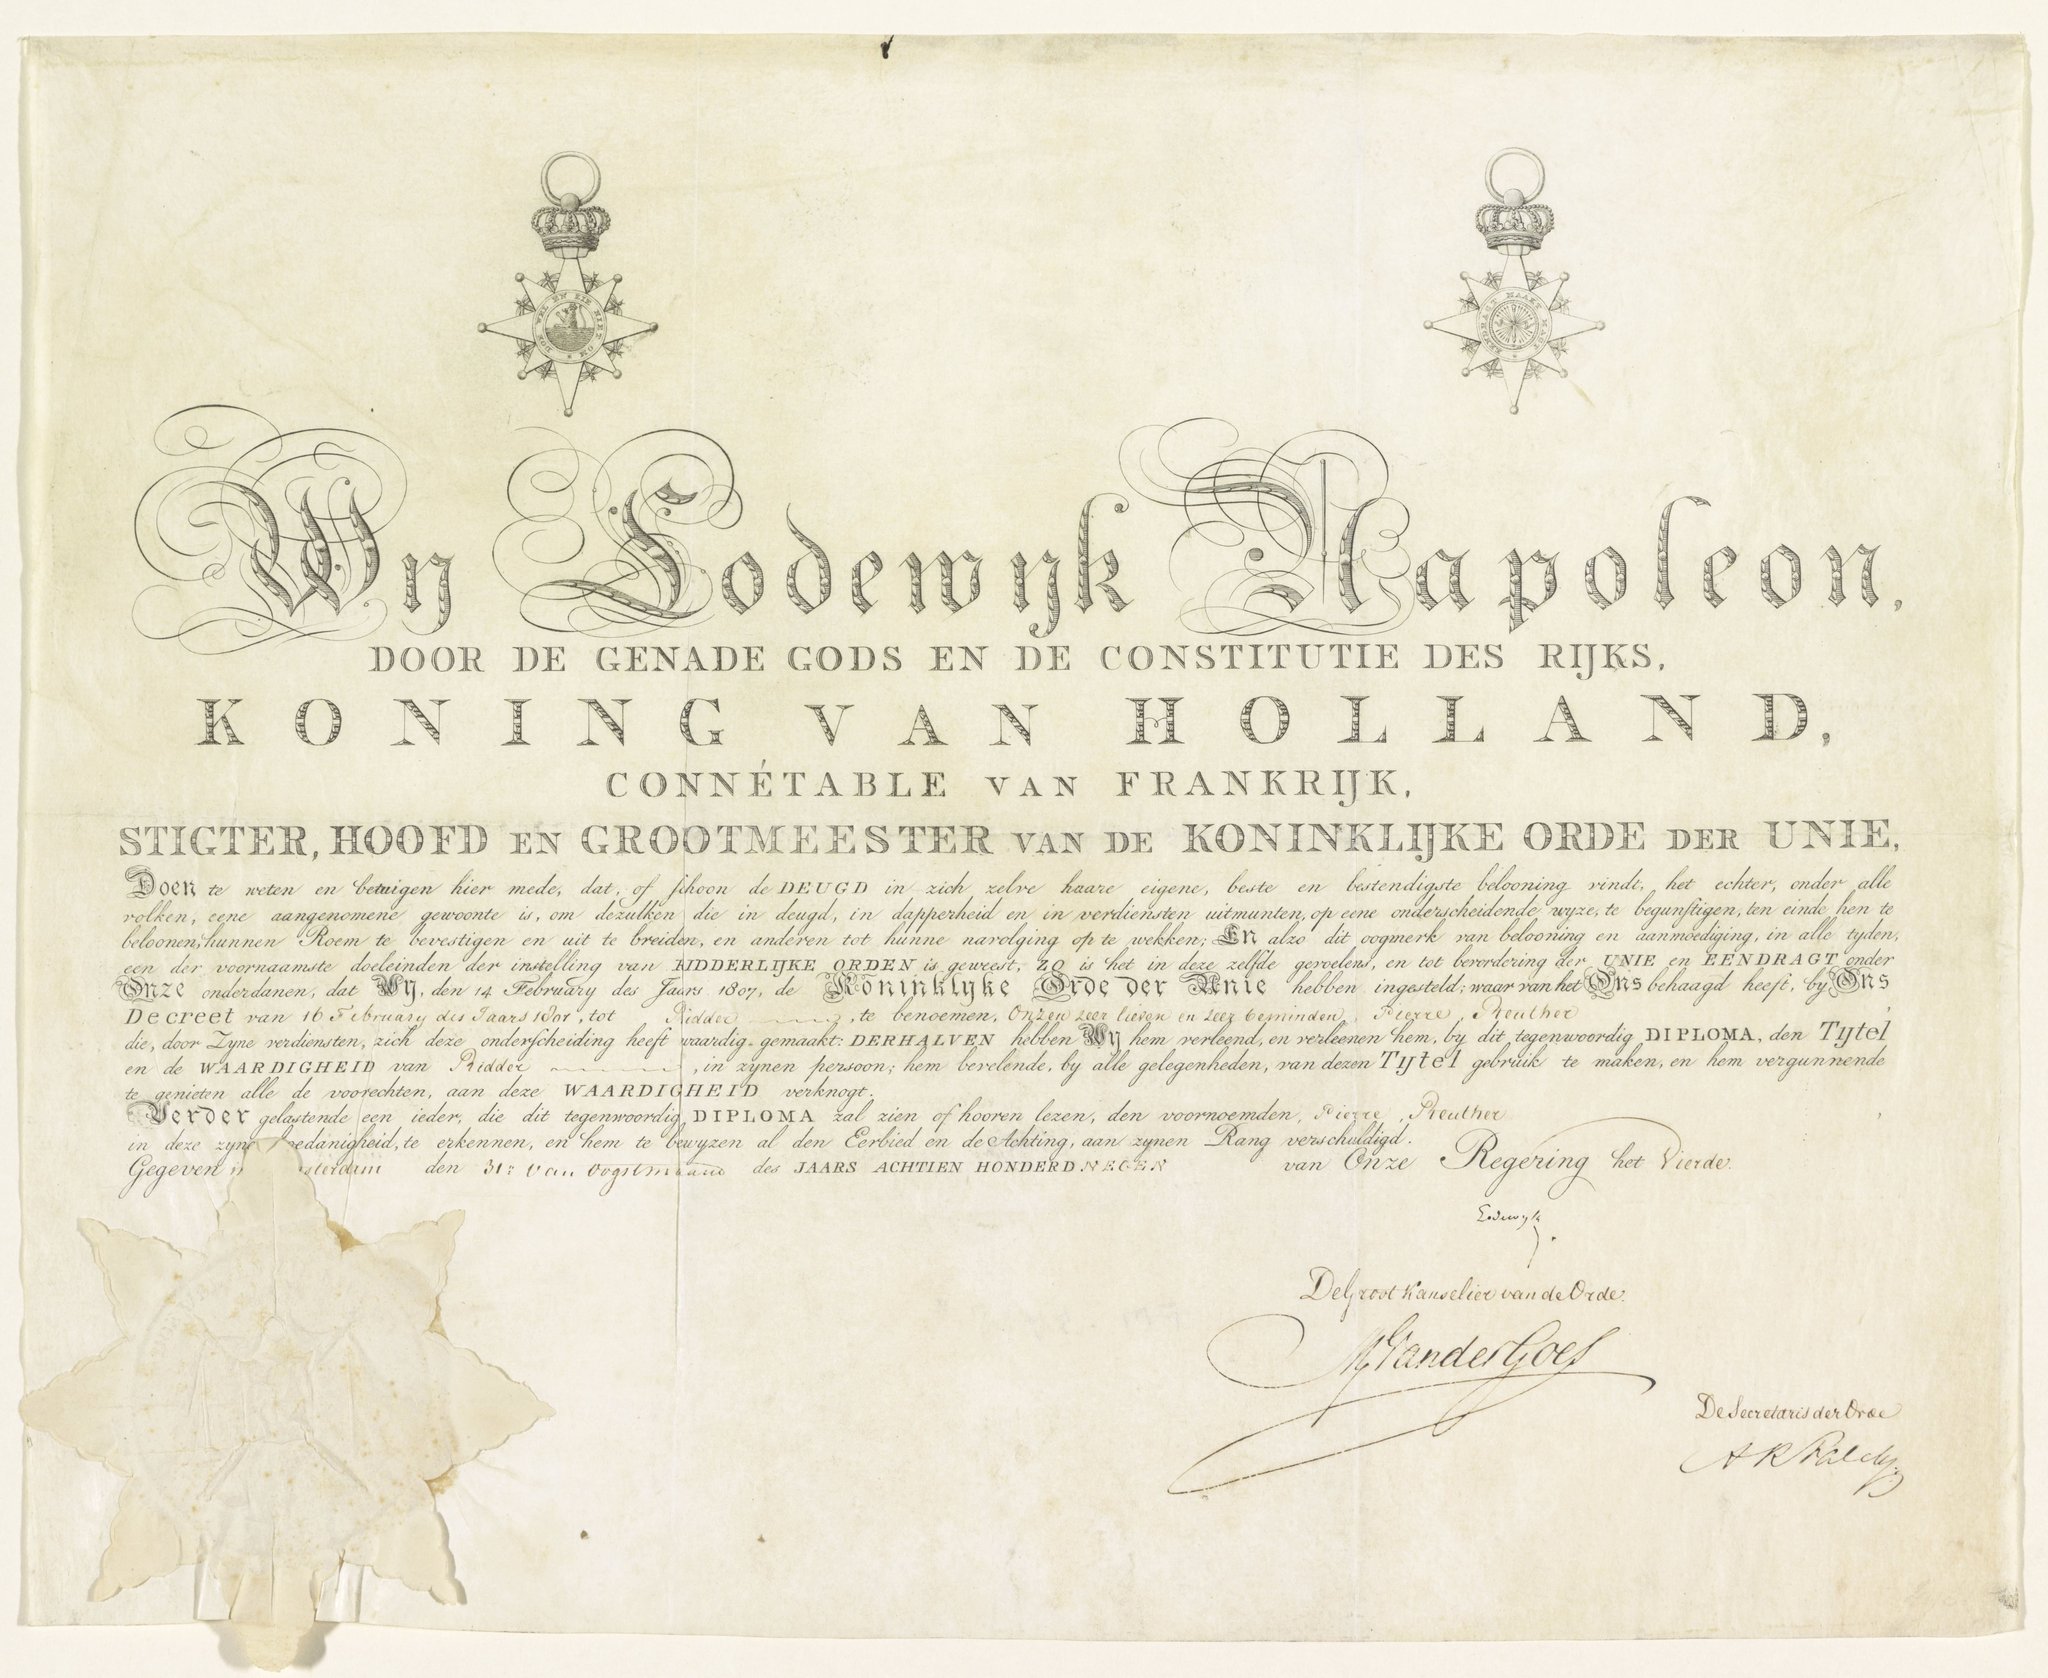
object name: print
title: Diploma voor P. Reuther bij zijn benoeming tot Ridder in de Orde van de Unie, 1809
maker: Anonymous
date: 1807-1809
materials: parchment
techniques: engraving, etching, writing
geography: netherlands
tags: louis napoleon (king of holland), knighthood order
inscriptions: collector's mark: Lugt 2228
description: Officieel diploma op naam van Pieter Reuther bij zijn benoeming tot Ridder in de Koninklijke Orde van de Unie, 31 juli 1809. Met het zegel van de Orde en ondertekend door de koning, grootkanselier en secretaris. Voorgedrukt diploma waarin met pen de naam en data zijn ingevuld. Bovenaan afbeeldingen van de voor- en keerzijde van het grootkruis.